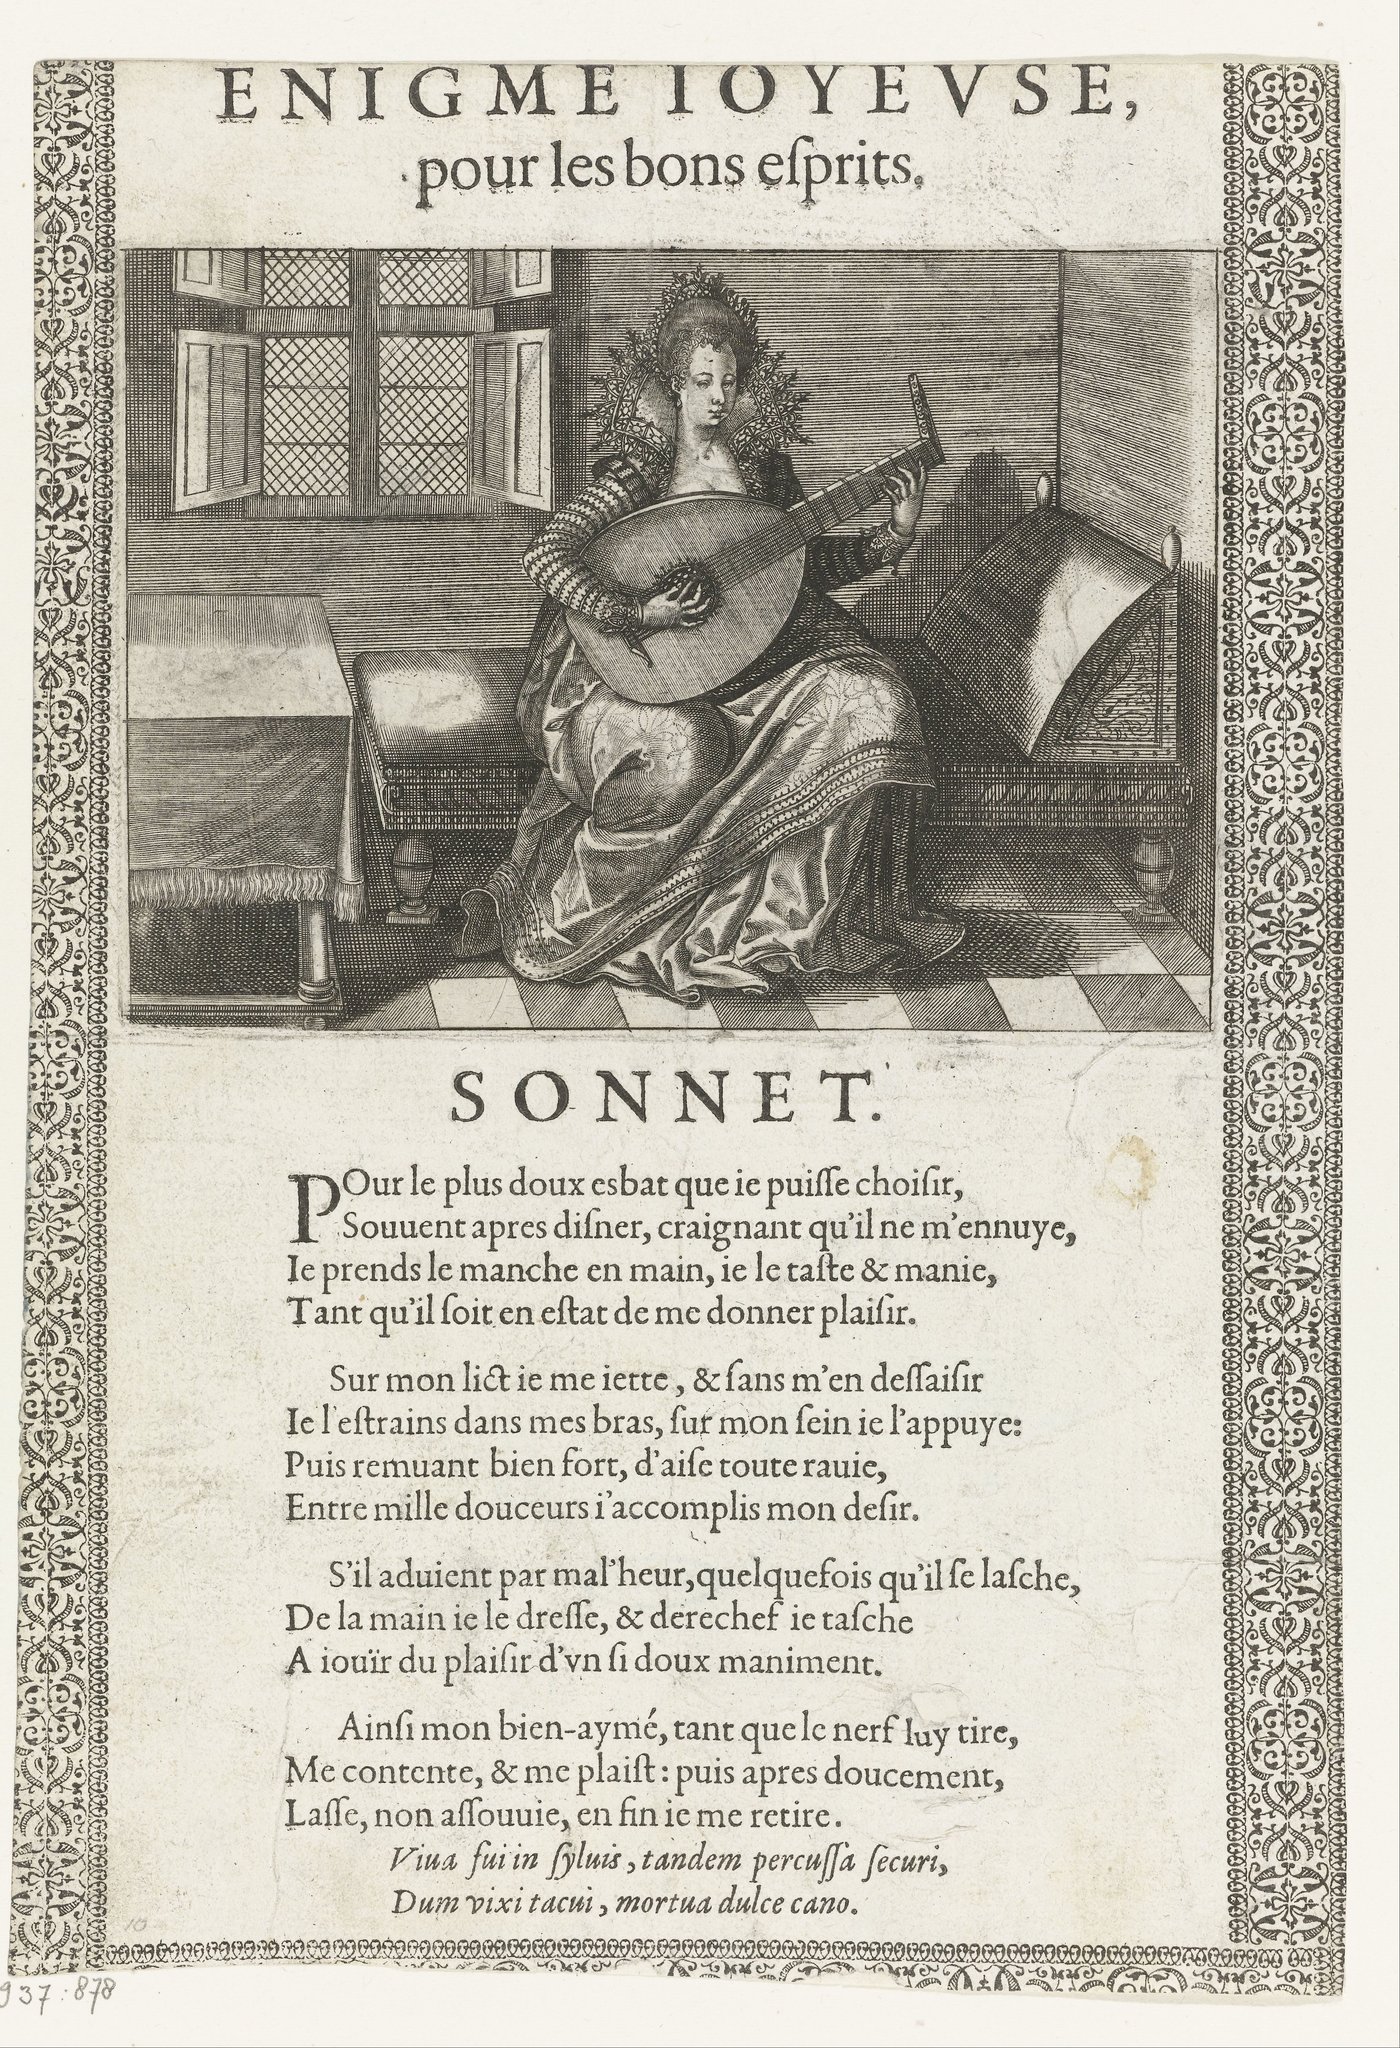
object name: print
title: Enigme Joyeuse, pour les bons esprits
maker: Anonymous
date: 1610-1680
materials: paper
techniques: engraving, etching, letterpress printing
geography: paris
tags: neck-gear: collar (+ women's clothes), dress, gown (+ women's clothes), bed, lute, and special forms of lute, e.g.: theorbo, one person playing an instrument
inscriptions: collector's mark: Lugt 2760, collector's mark: Lugt 2228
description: Notitie mevr. De Hoop Scheffer op opzetkarton: Eén prentje (zonder tekst) gesigneerd Van Halbeeck. De andere uit de serie (met teksten in kader) zijn kopieën. De originelen zijn (niet compleet) in een verzamelband in bezit van de heer Van Hattum te Santpoort (maart 1965). Kleinere kopieën door Cr. de Passe (KB Den Haag), Franken 1352. Vergelijk ook dezelfde serie door Mattheus Merian: Emblemata Amatoria (Wühtrich I, p. 20, no. 12 + afb. 38, 39, 40).